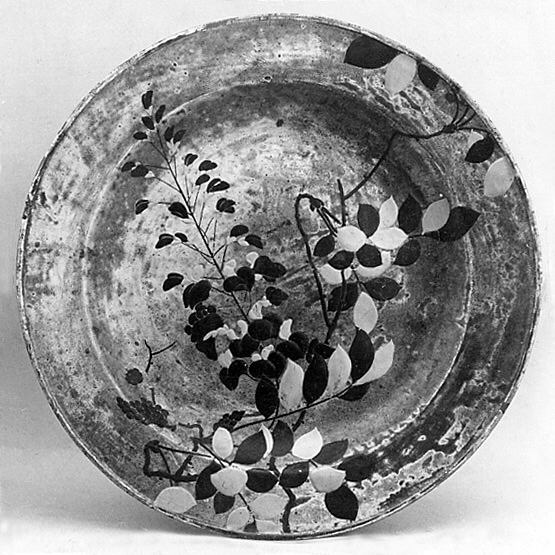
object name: plate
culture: japanese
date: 1701-1800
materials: copper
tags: leaves